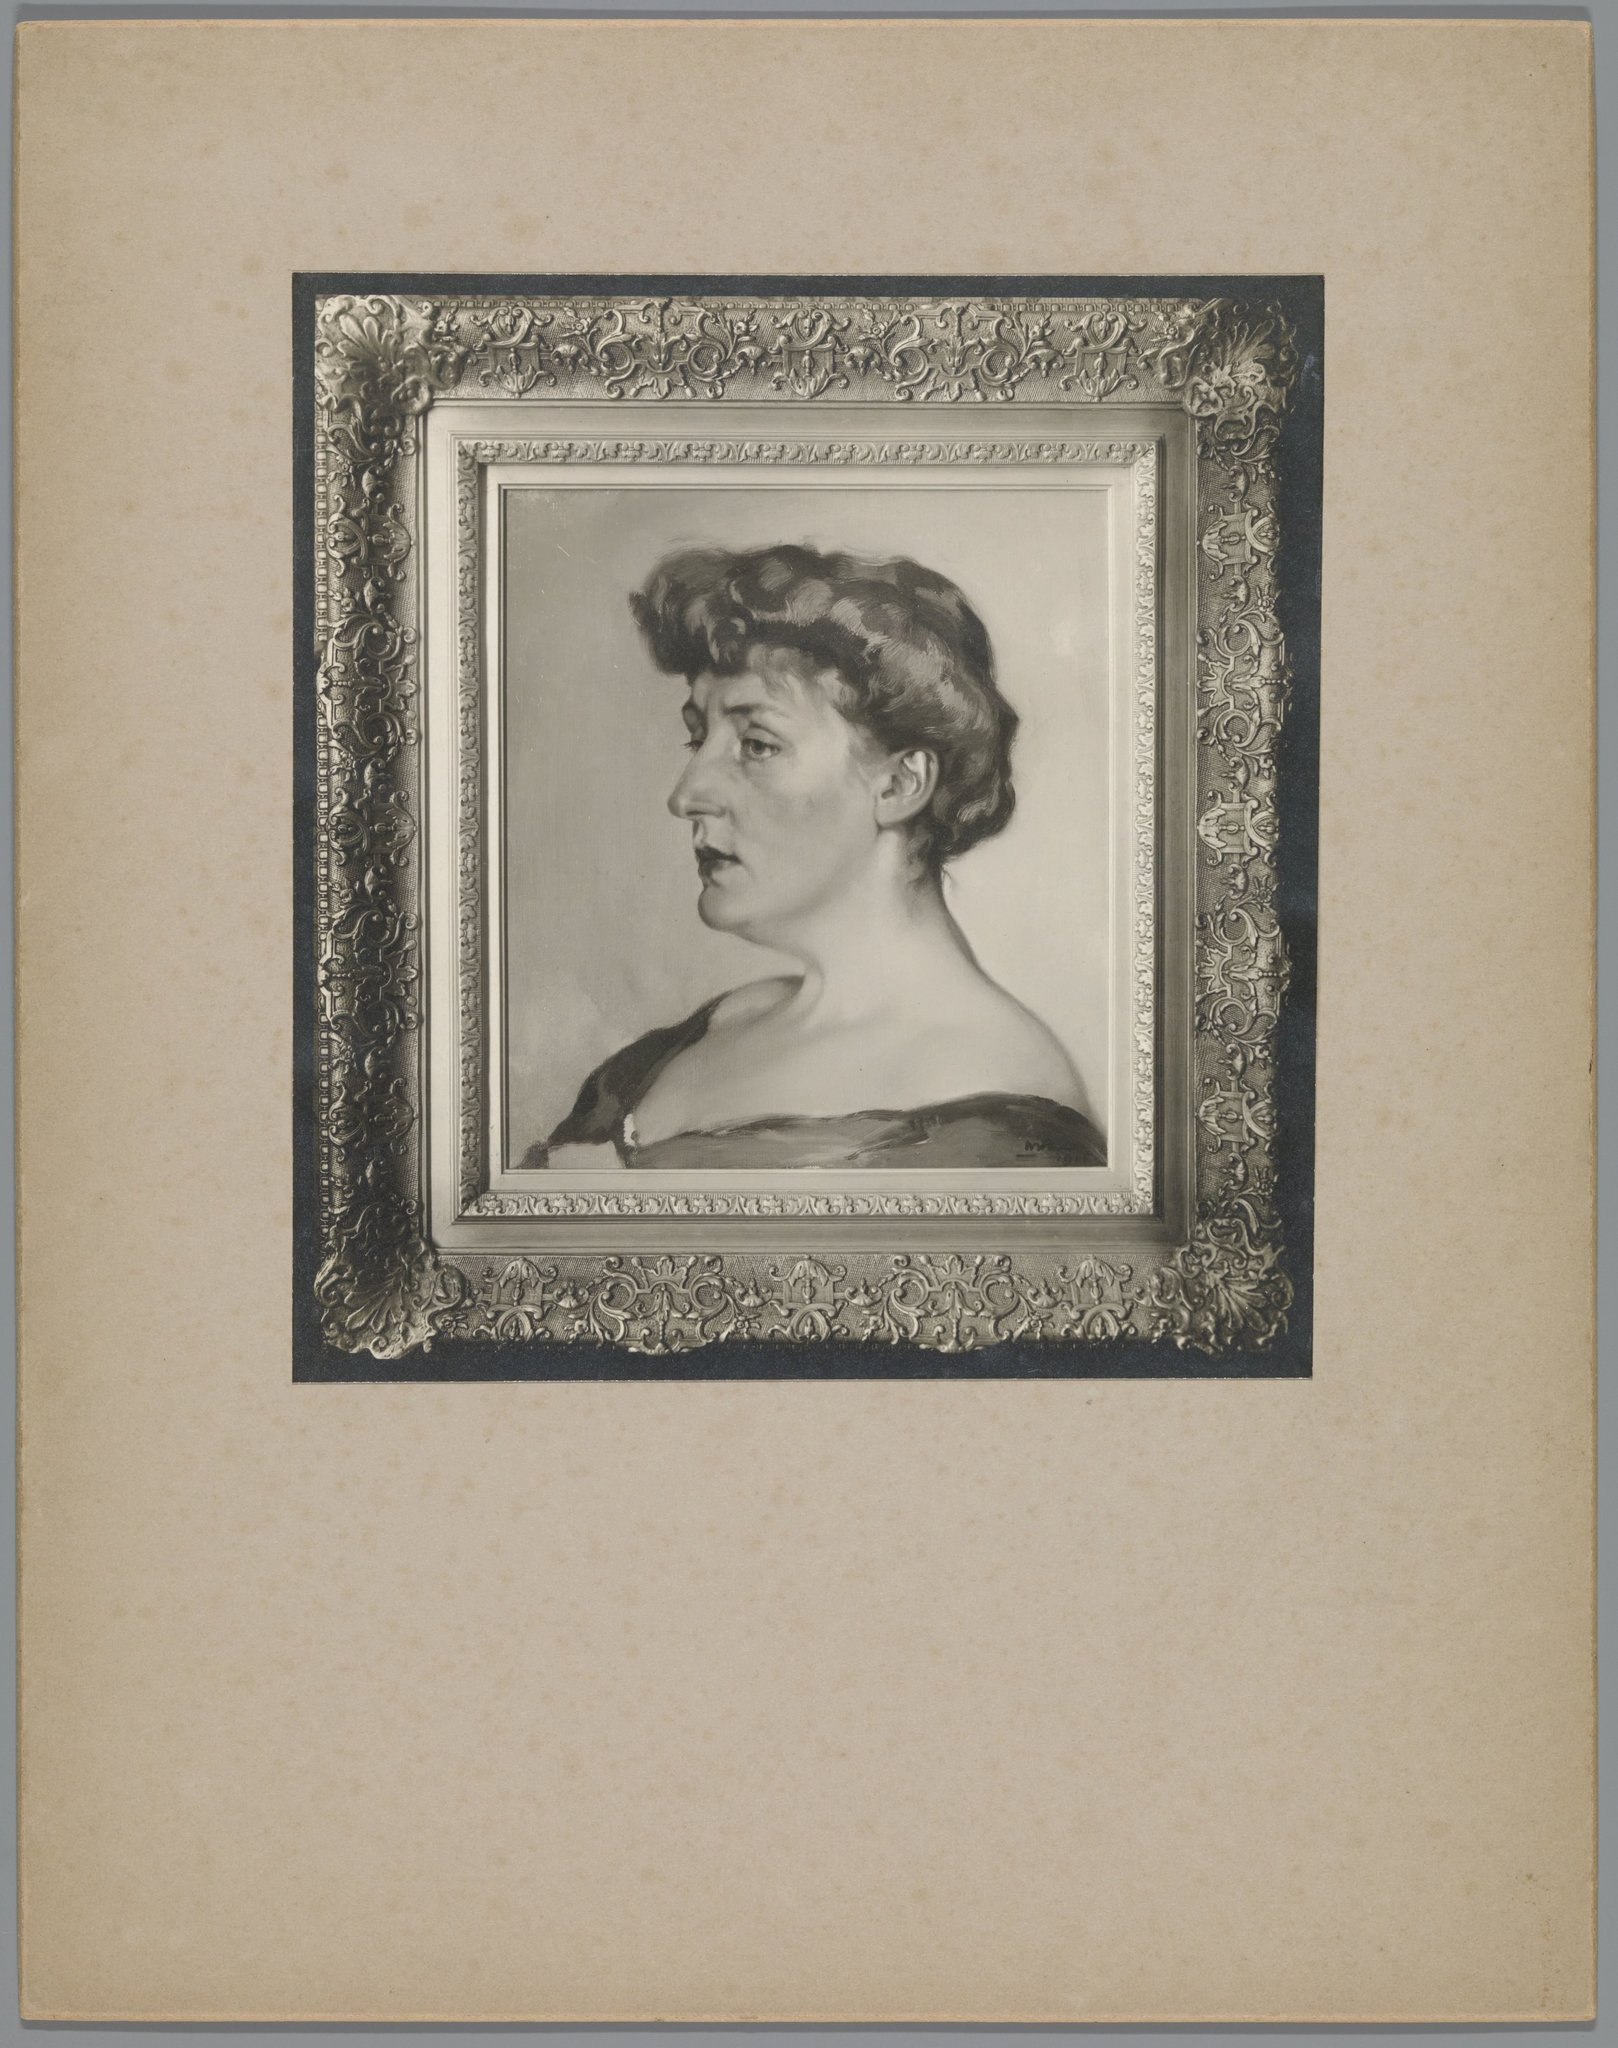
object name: photograph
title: Reproductie naar schilderij van Willem Witsen van een portret van een vrouw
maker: Anonymous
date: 1860-1915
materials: cardboard, paper, photographic support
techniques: gelatin silver print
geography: netherlands